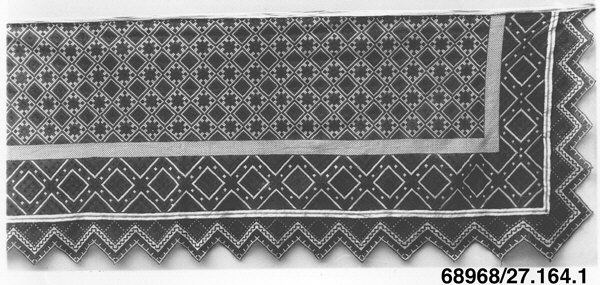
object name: scarf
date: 1801-1900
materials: linen